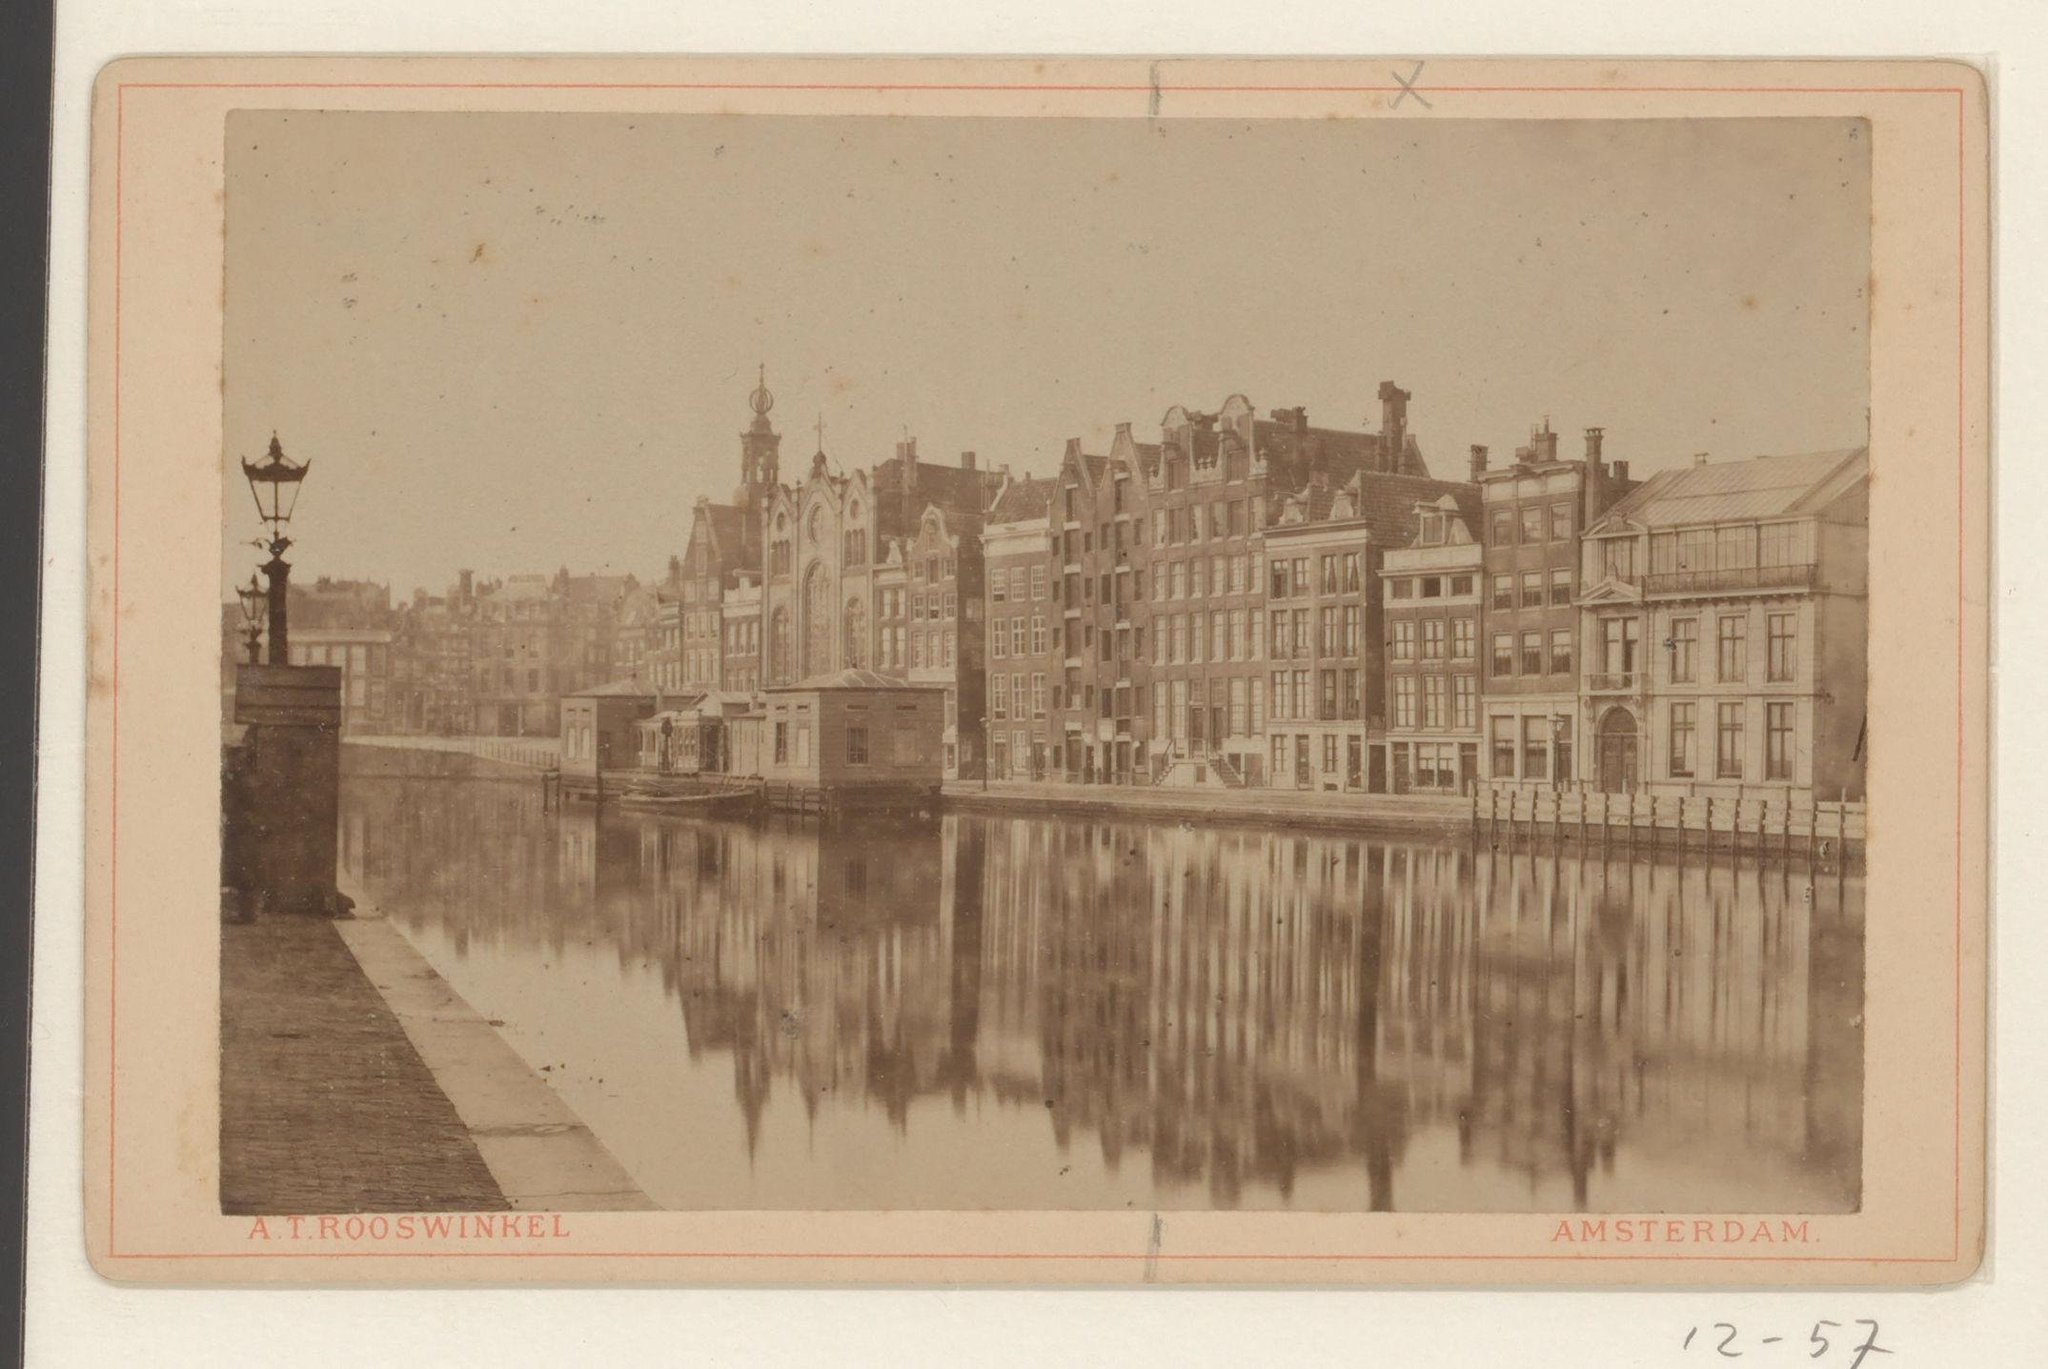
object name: cabinet photograph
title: Gezicht op het Rokin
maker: andreas theodorus rooswinkel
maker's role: fotograaf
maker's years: 1838-1909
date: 1875-1896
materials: cardboard, paper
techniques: albumen print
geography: amsterdam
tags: city-view in general; 'veduta', canal, the usual house or row of houses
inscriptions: inscription: ‘Rokin. / 36.’, stamp: ‘Gebr. Douwes / Atelier / Grimburgwal 15 / Amsterdam.’, collector's mark: ‘12,57’ Lugt 1641b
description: Onderwerpsrubriek binnen de Atlas Amsterdam: Rokin, Rotterdammersloot, Rozengang, Rozengracht, Rozenstraat, Rusland, Rustenburgerstraat, Ruysdaelkade, Ruysdaelstraat, Ruyterkade (de), Ruyterweg (Admiraal de).